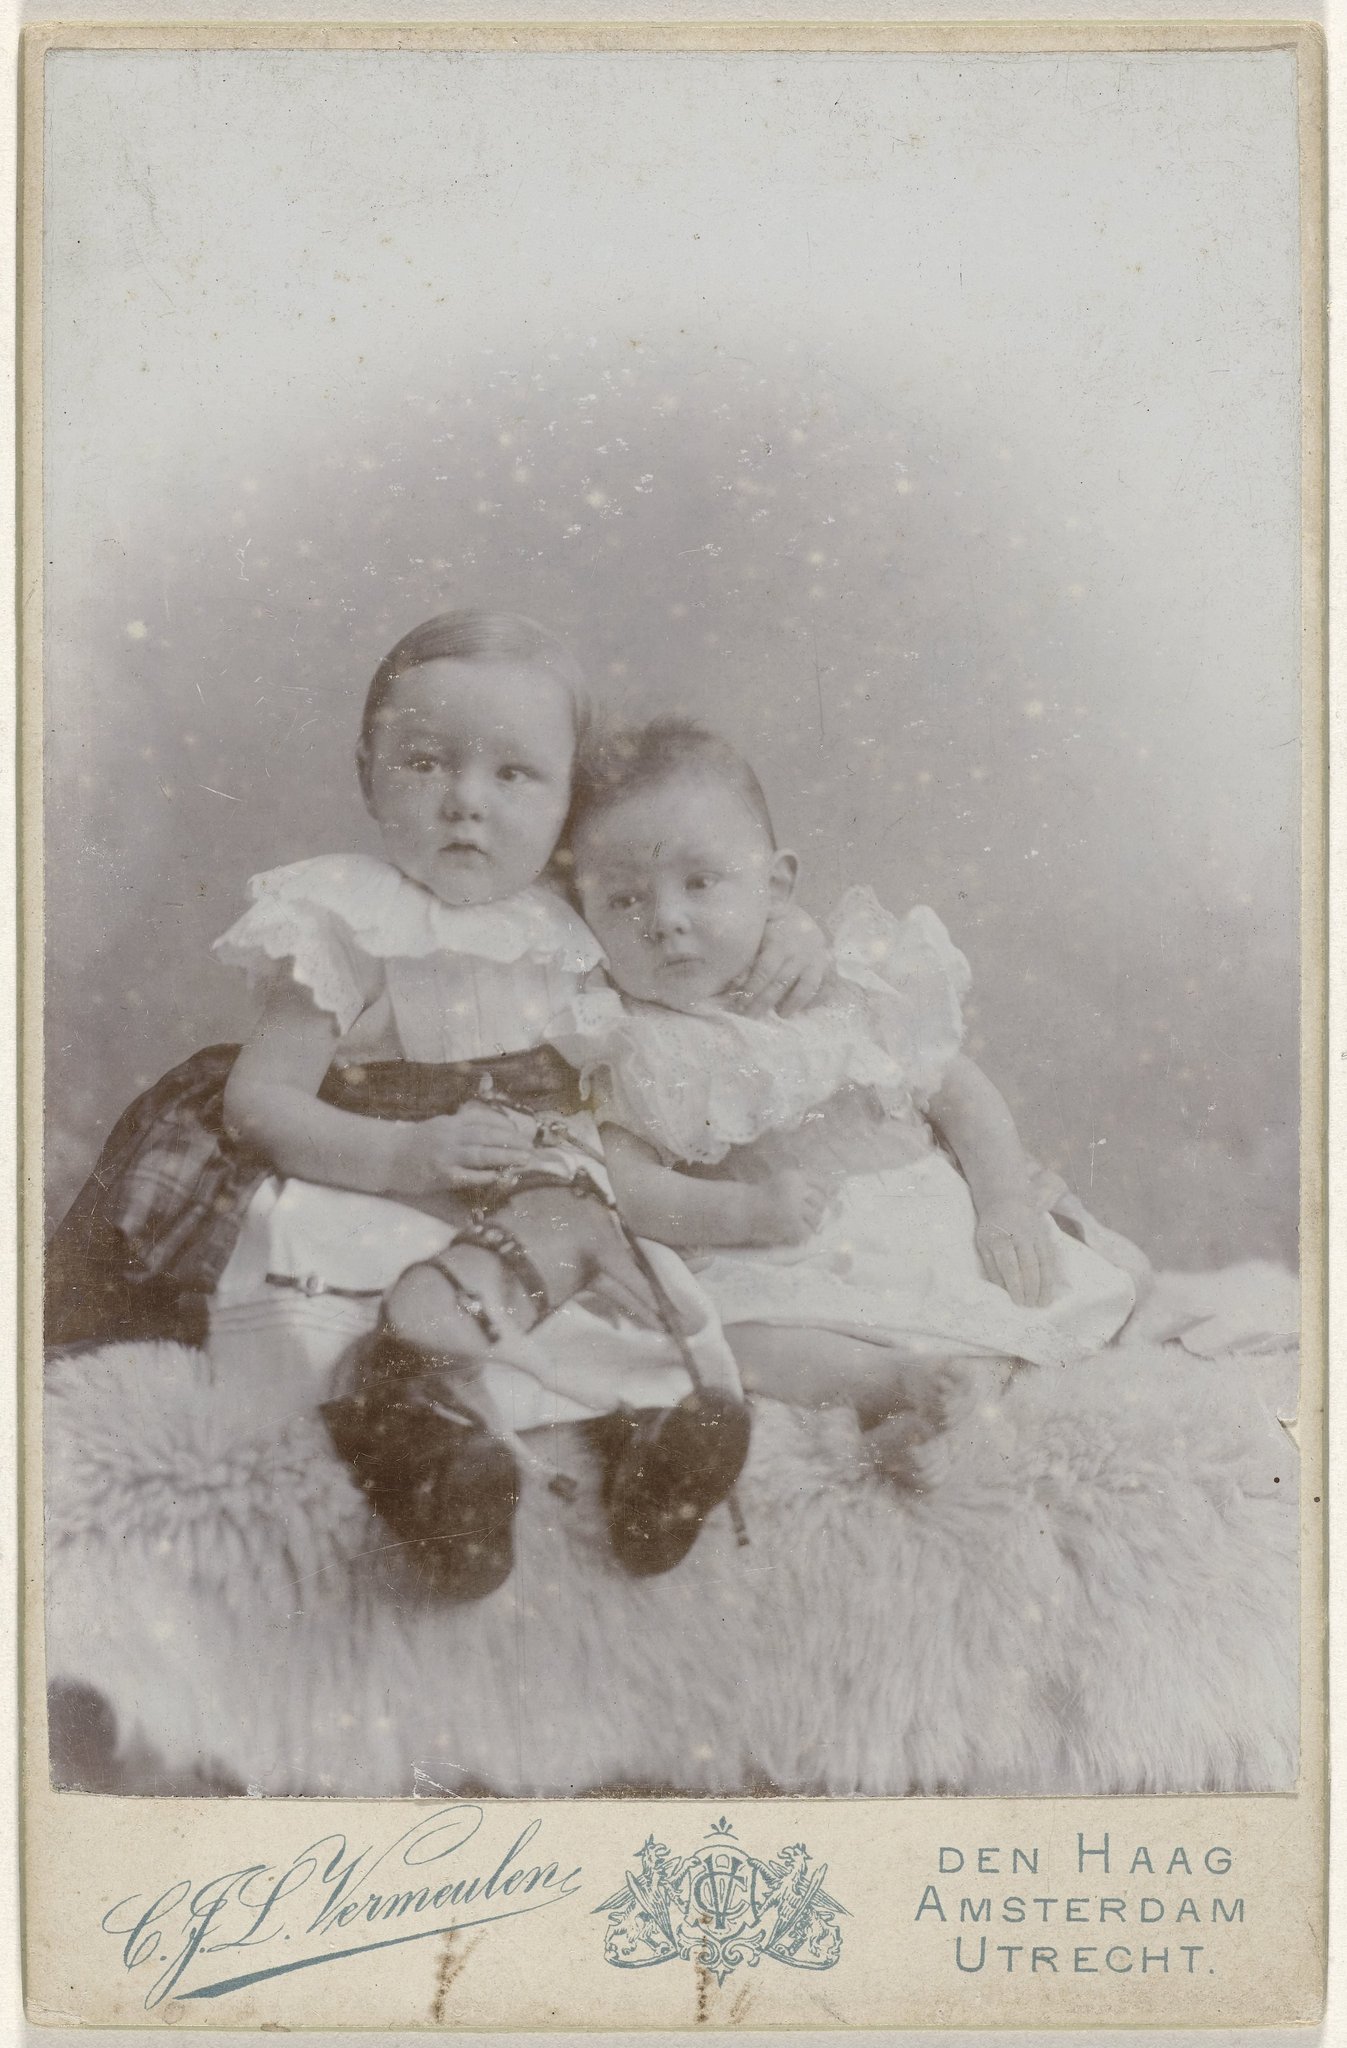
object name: cabinet photograph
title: Portret van twee babies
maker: cornelis johannes lodewicus vermeulen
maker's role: fotograaf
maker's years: 1861-1936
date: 1899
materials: cardboard, photographic support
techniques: collodion silver print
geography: the hague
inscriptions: inscription: ‘C.J.L. Vermeulen, Den Haagm Ansterdan, Utrecht’